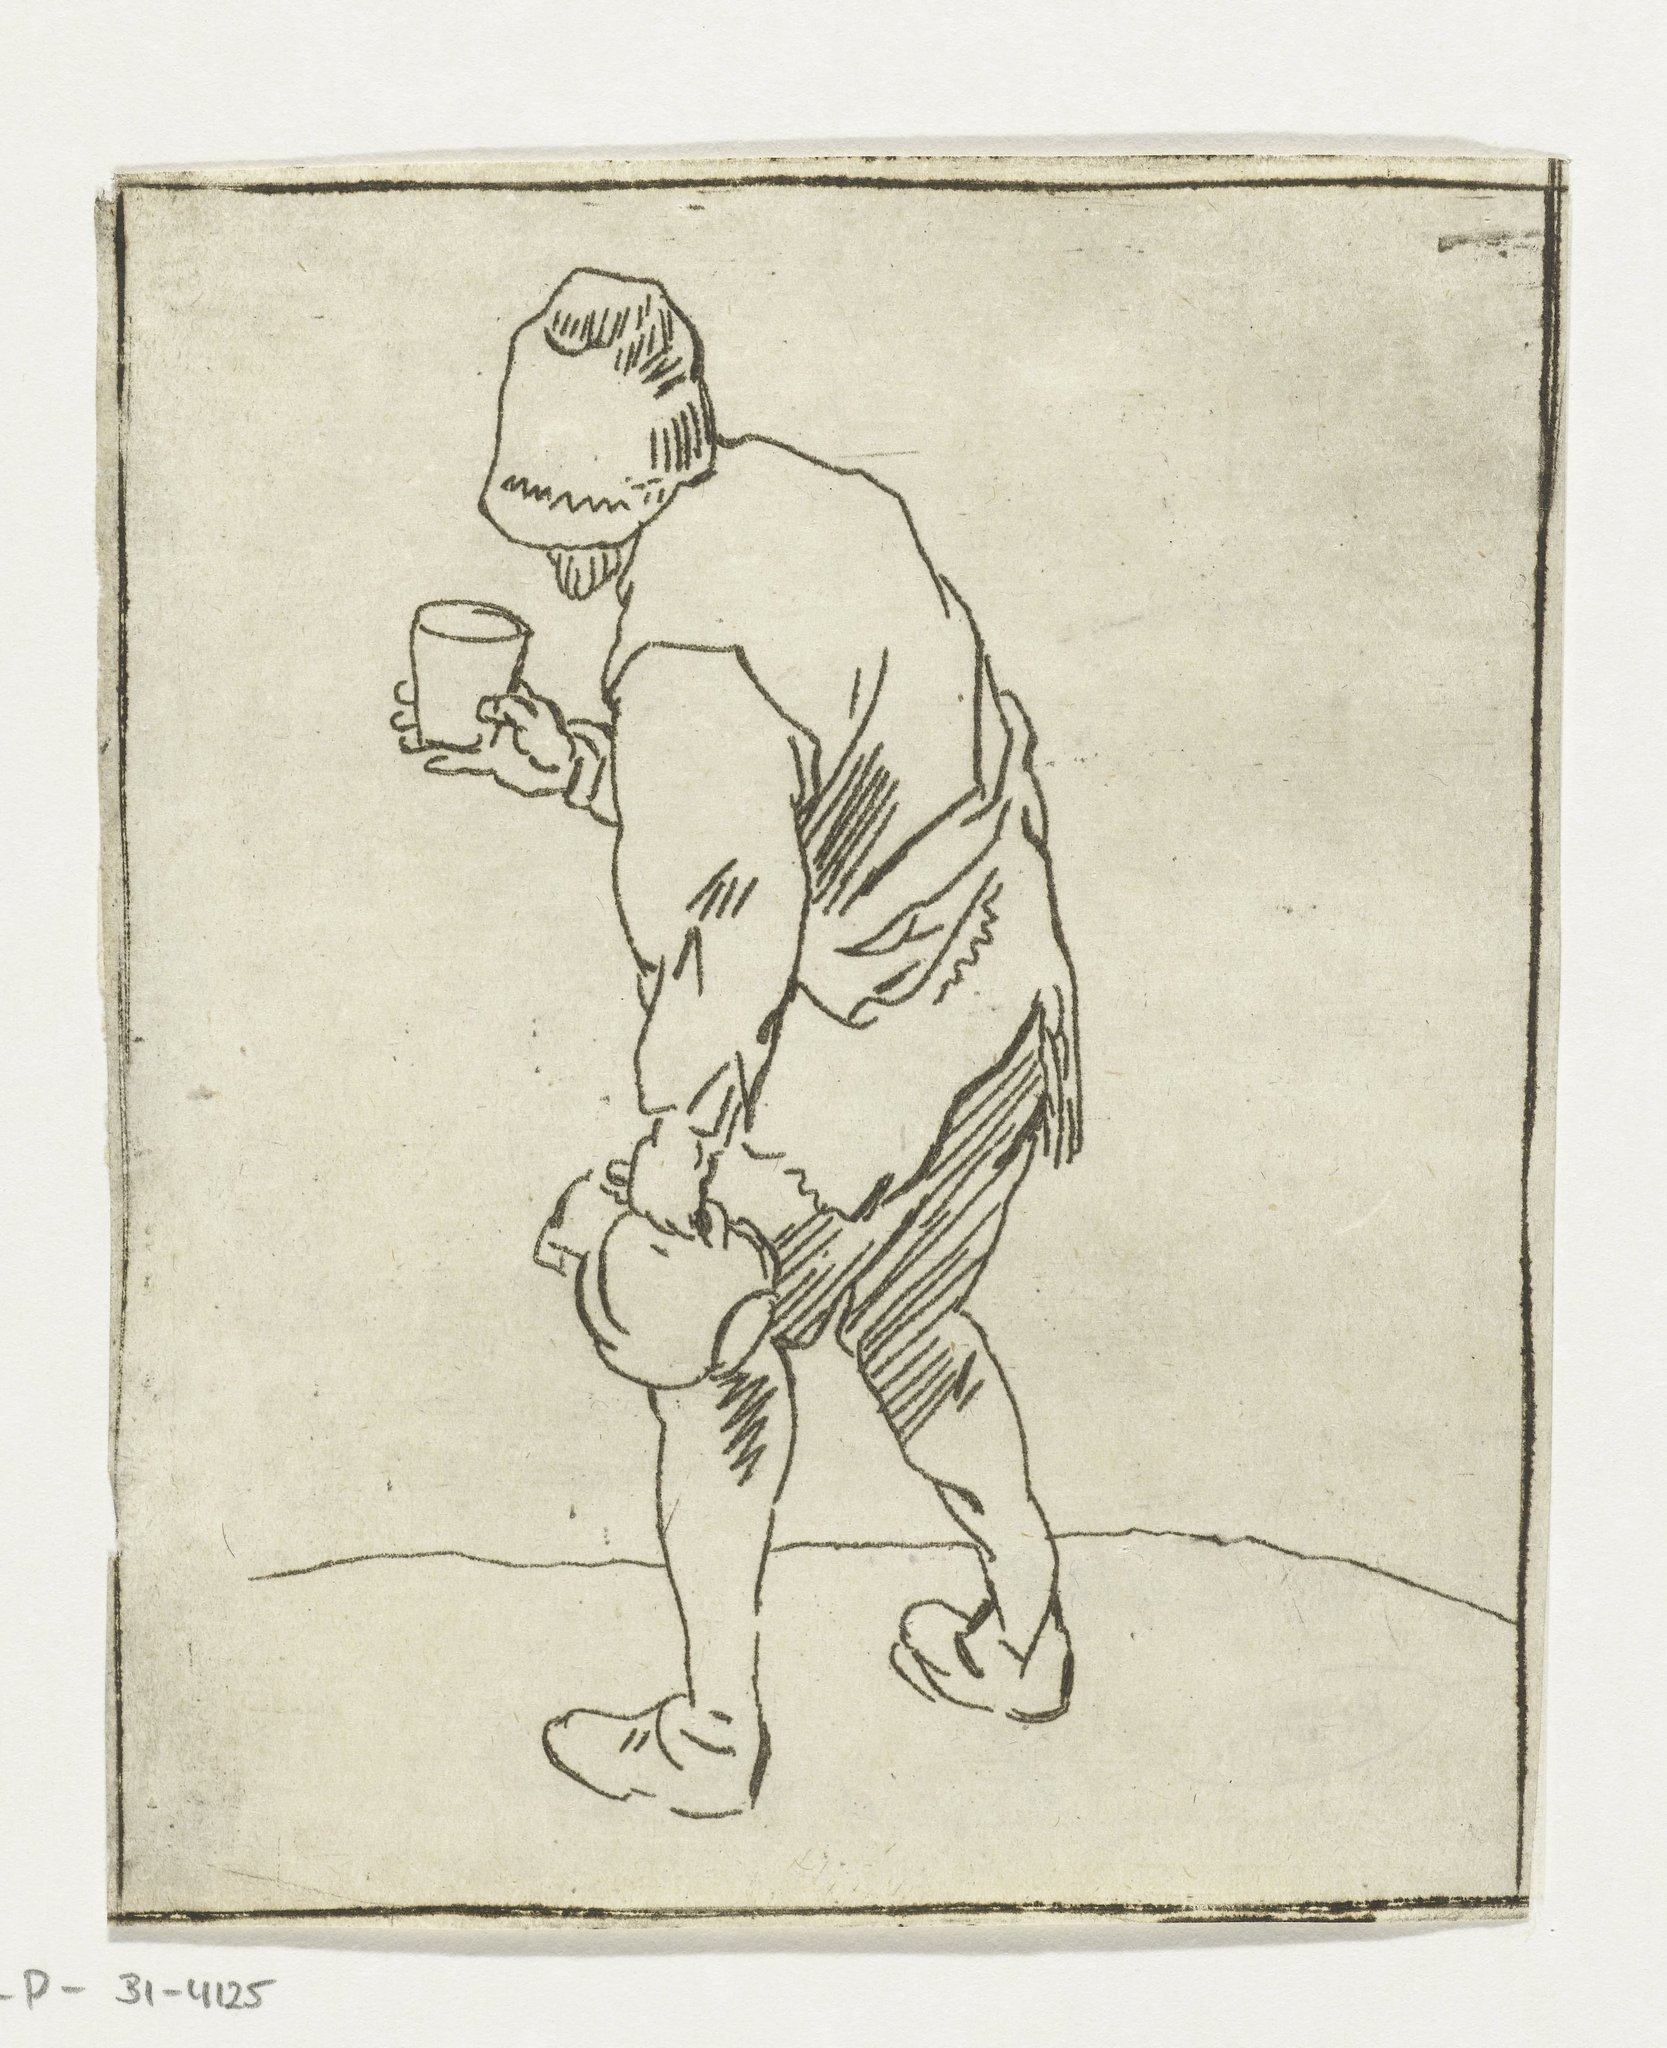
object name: print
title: Man met kruik en glas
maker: anthonie van den bos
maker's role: draughtsman, print maker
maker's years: 1763-1838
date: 1778-1838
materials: paper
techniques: etching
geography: netherlands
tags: drunkard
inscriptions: collector's mark: Lugt 2228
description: Een man met een glas in zijn hand en een kruik in zijn andere hand op zijn rug gezien.